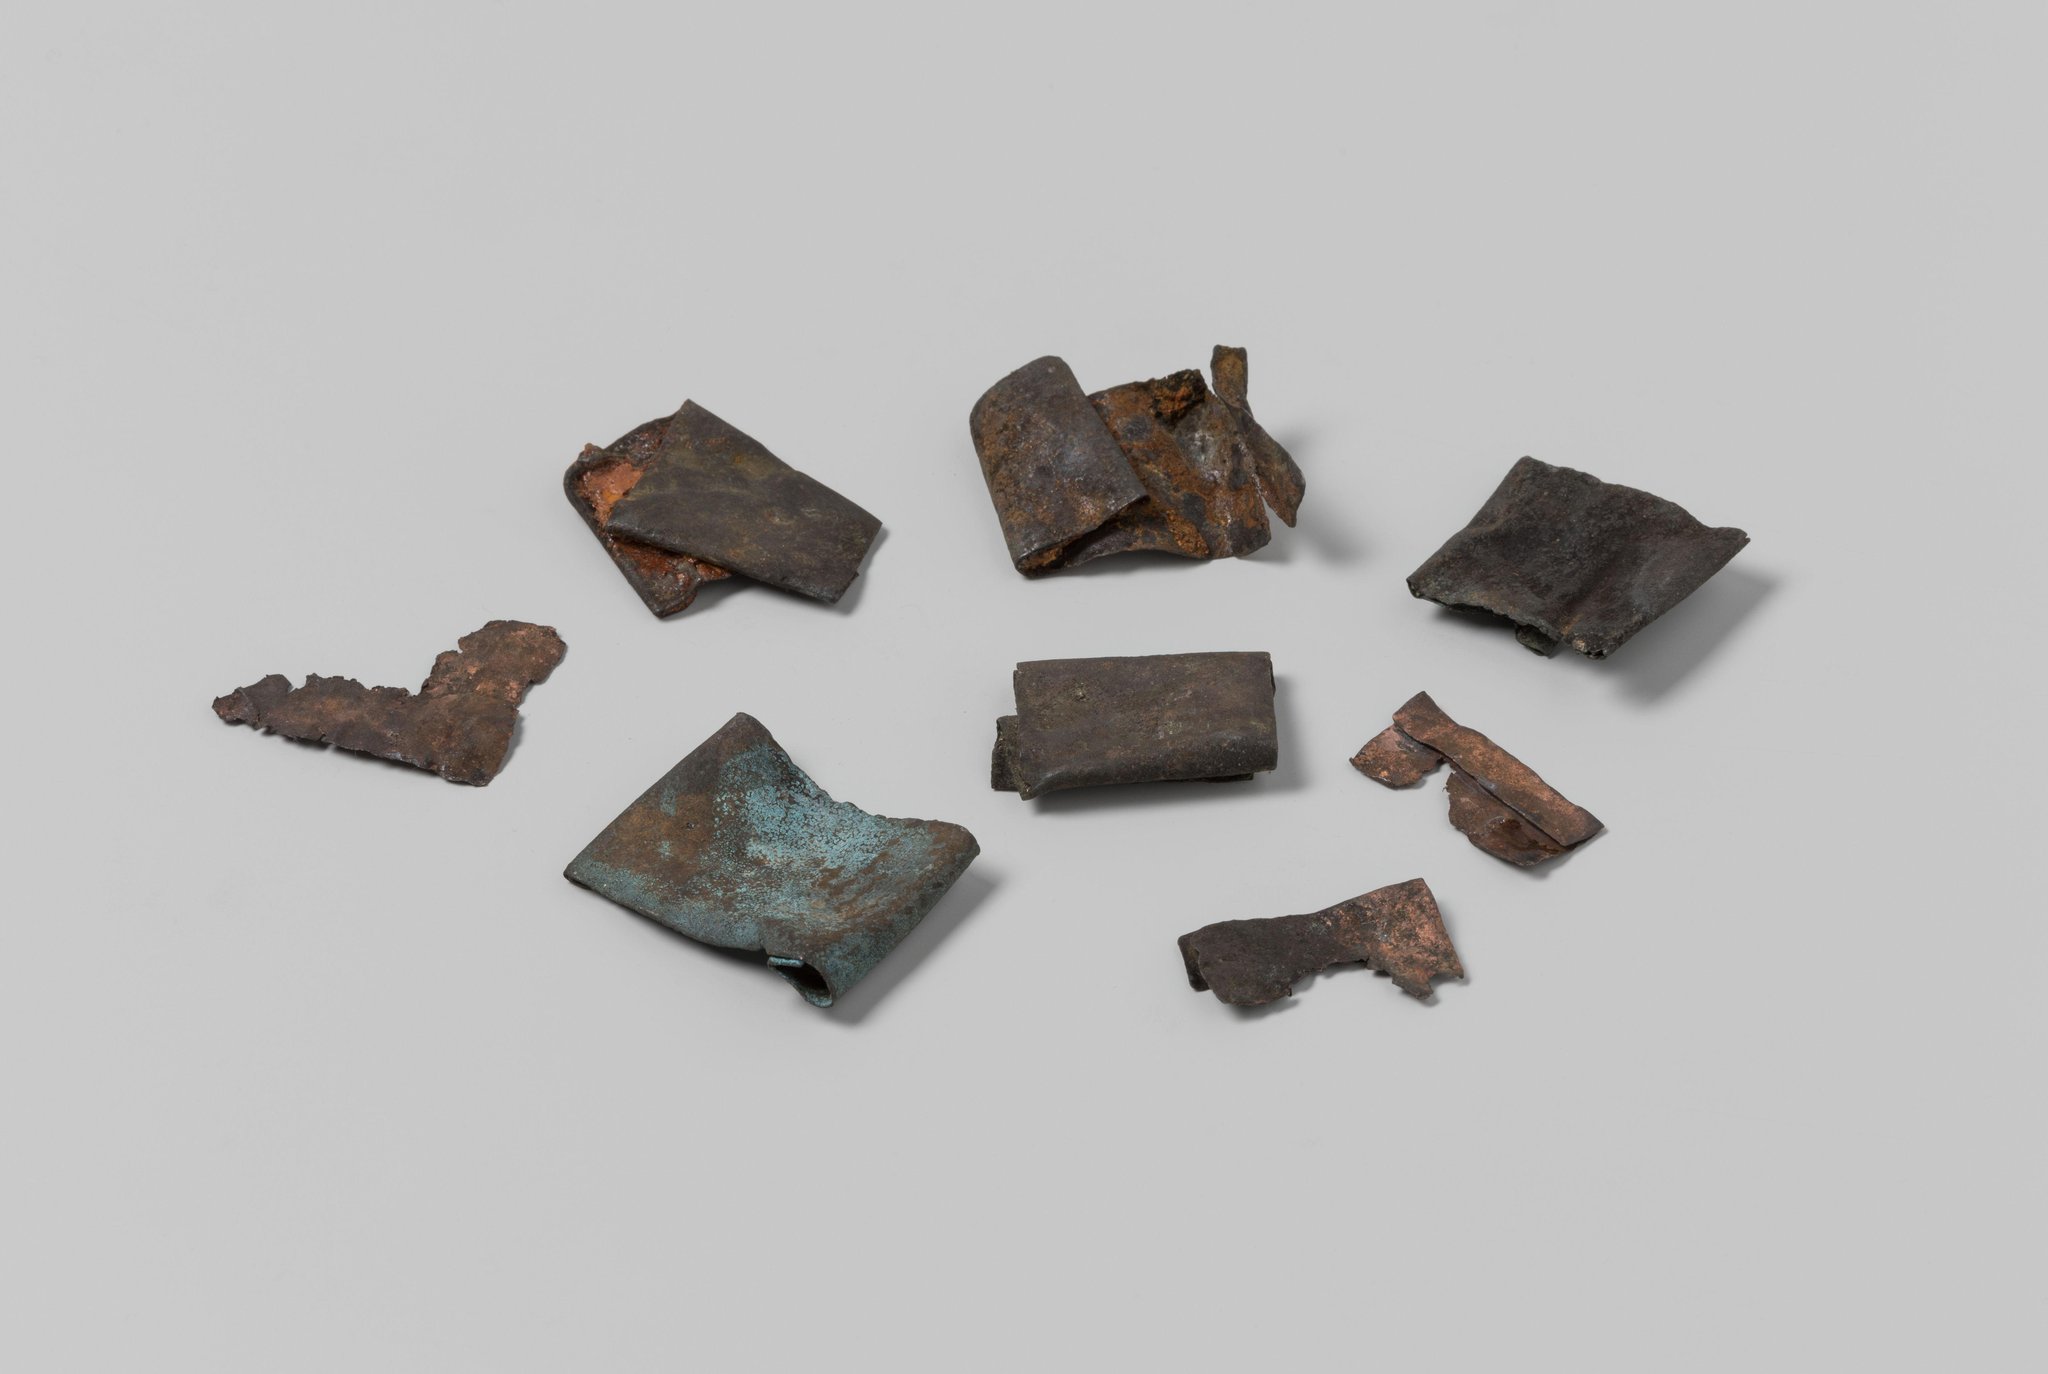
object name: beslag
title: Fragmenten beslag uit het wrak van de Oost-Indiëvaarder Hollandia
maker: Anonymous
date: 1700-1743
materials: copper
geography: netherlands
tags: verenigde oostindische compagnie, hollandia (schip), annet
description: Fittings, bands and bracing, flat; fragm, squashed, id. NG 1980-27H1868.